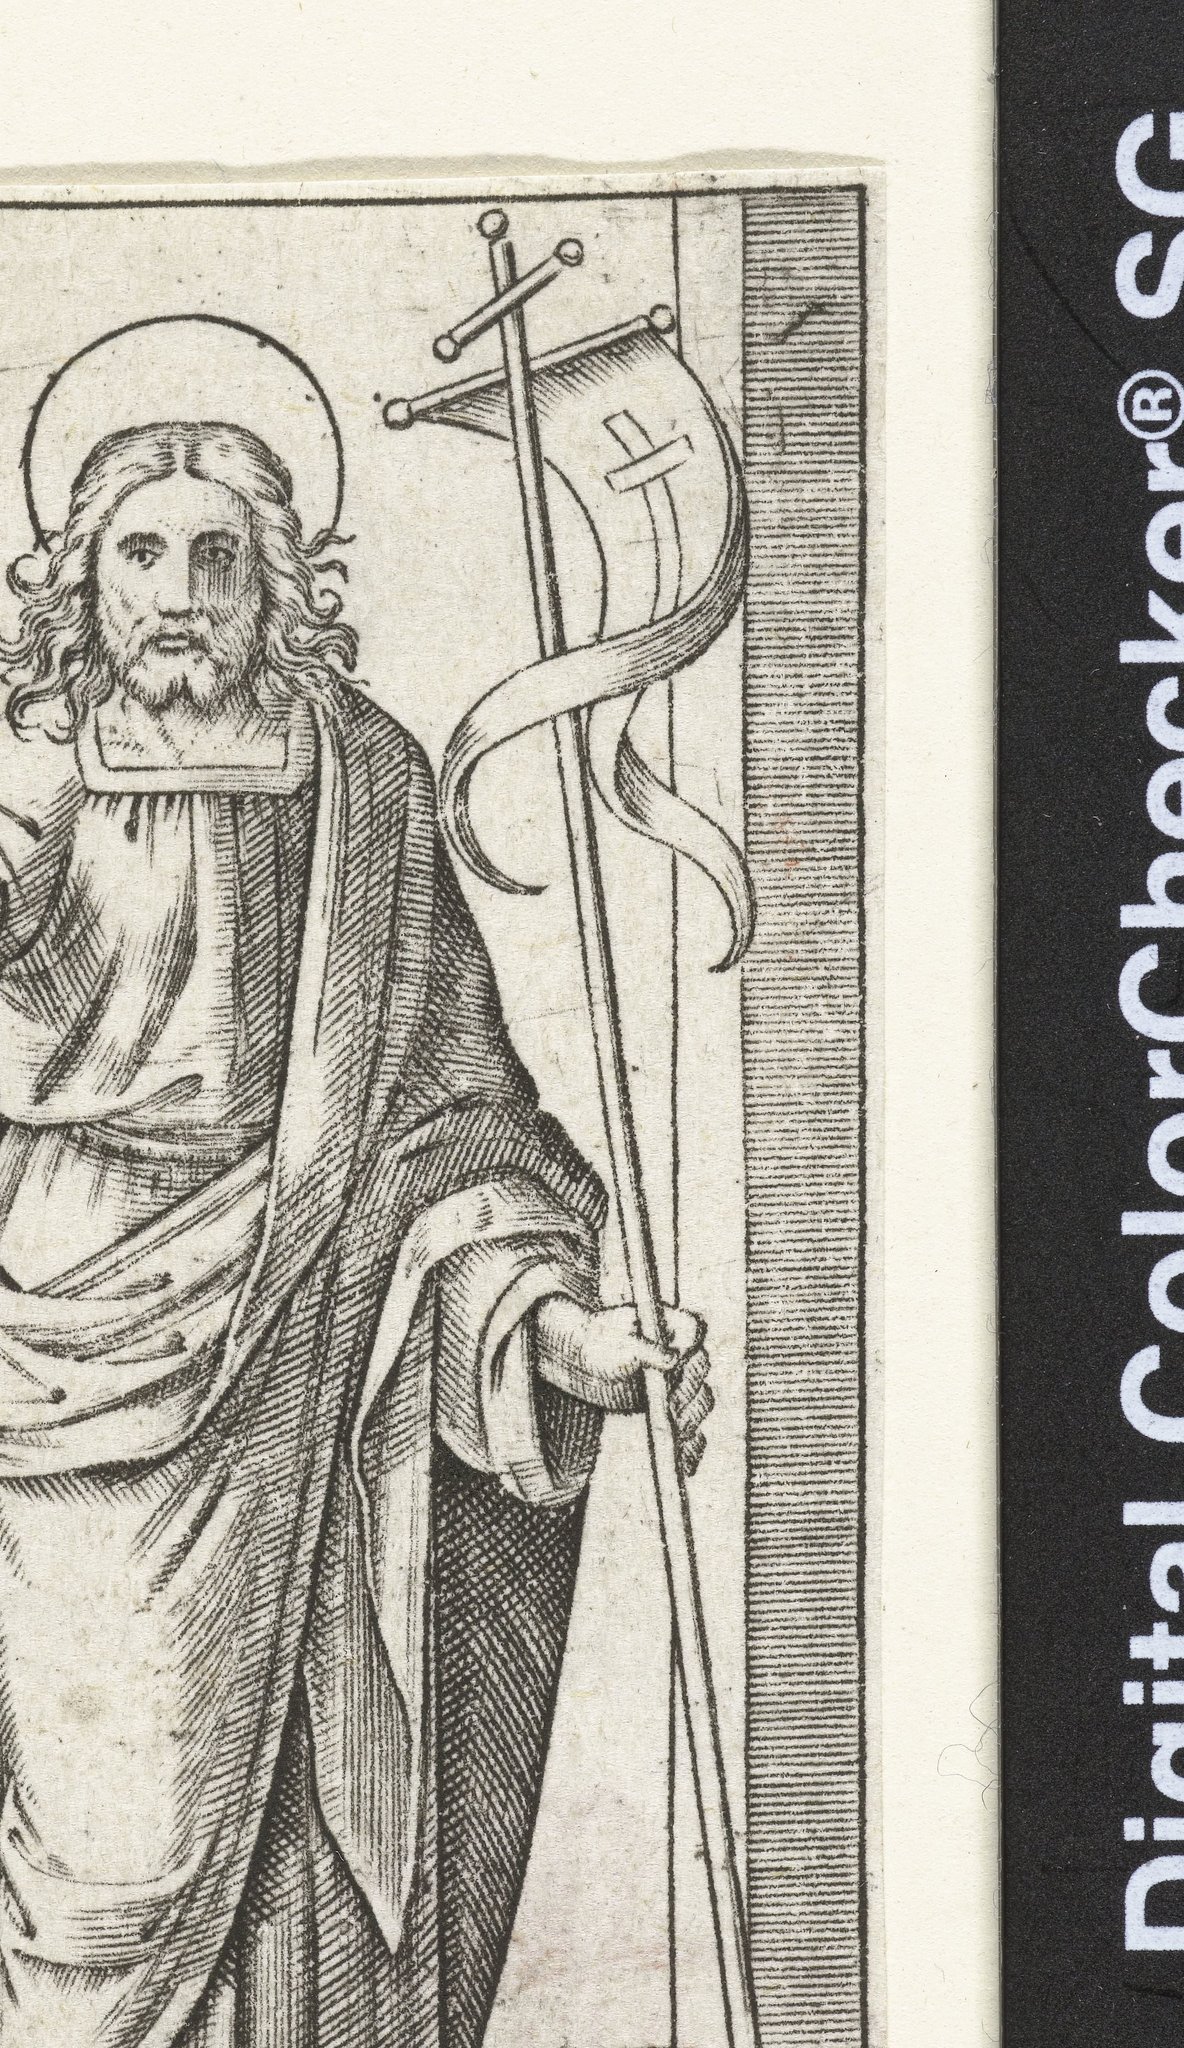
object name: print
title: Christus met kruisvaandel maakt zegenend gebaar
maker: Anonymous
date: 1517-1577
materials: paper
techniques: engraving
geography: italy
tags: 'salvator mundi', making a blessing gesture; an orb in his hand or at his feet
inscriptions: collector's mark: Lugt 12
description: Kopie naar prent van Marcantonio Raimondi. Raimondi vervaardigde de serie van dertien kleine prenten van Christus en de apostelen naar ontwerp van Raphael.